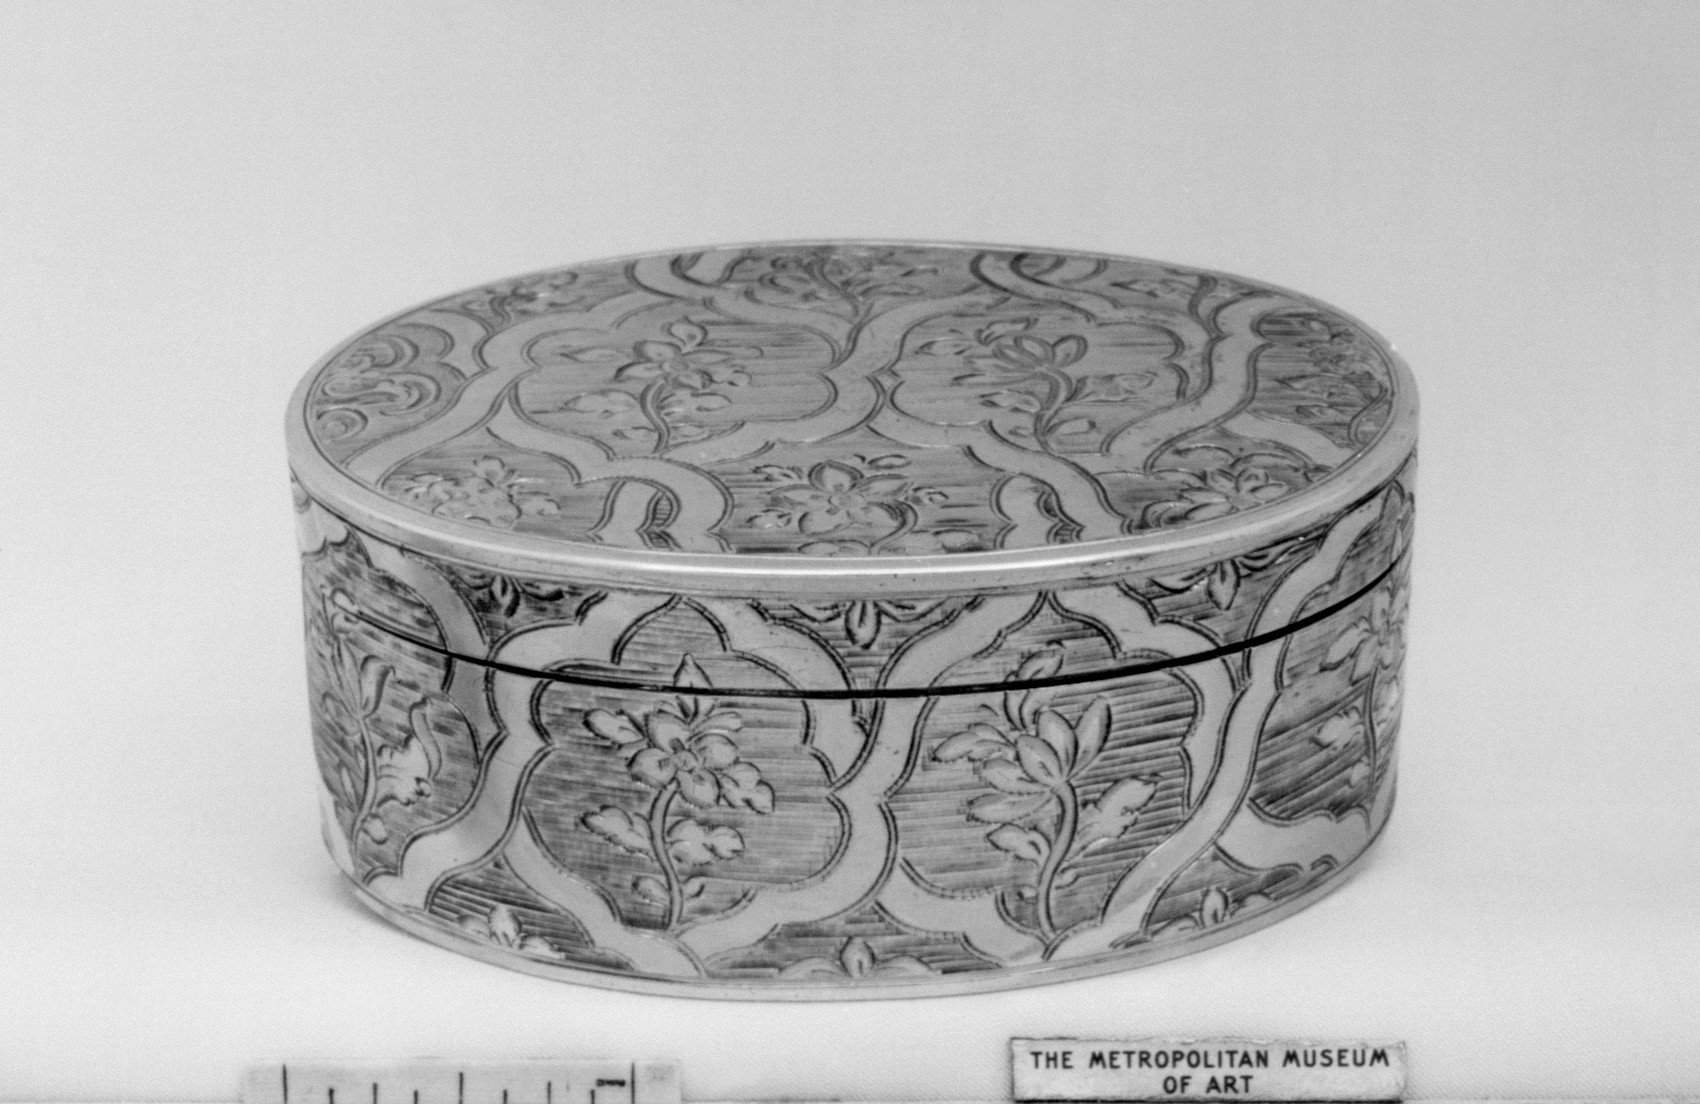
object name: box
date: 1701-1800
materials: gilt, silver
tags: flowers